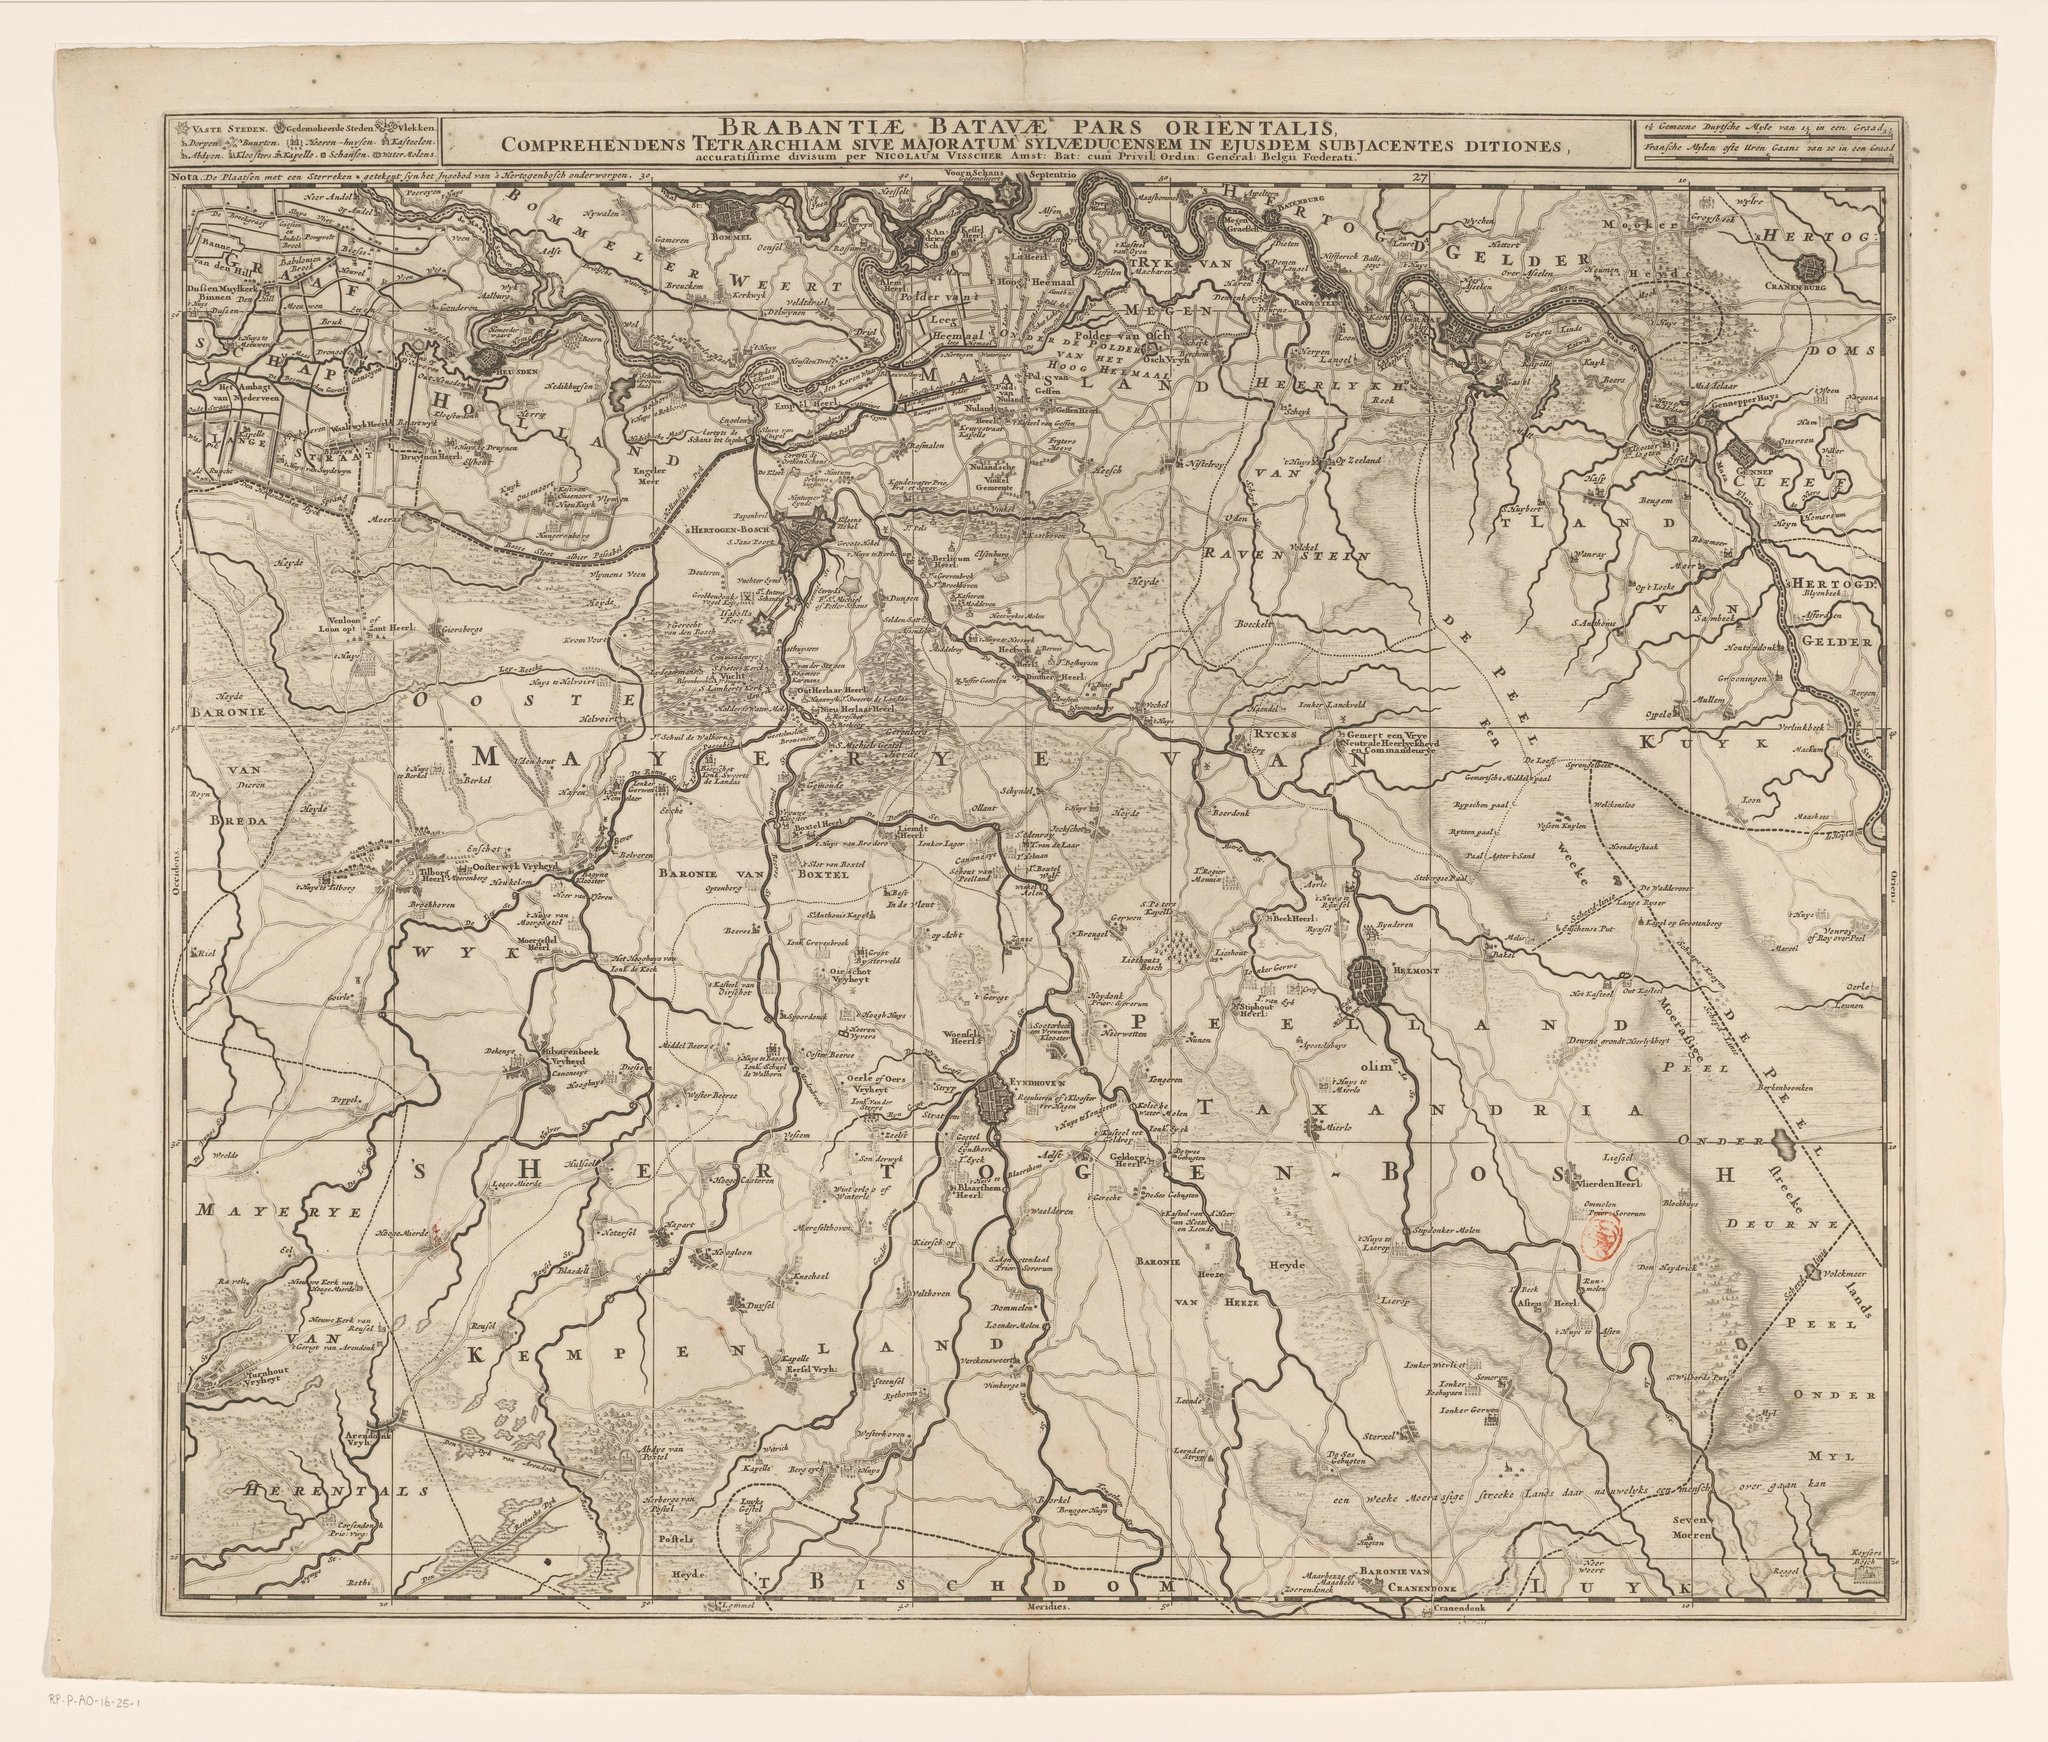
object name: map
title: Brabantiae Batavae pars orientalis comprehendens tetrarchiam sive majoratum Sylvaeducensem in ejusdem subjacentes ditiones (...)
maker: Anonymous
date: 1677-1720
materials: paper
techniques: engraving, etching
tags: maps of separate countries or regions, brabant, den bosch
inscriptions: collector's mark: Lugt 195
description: Kaart van het oostelijk deel van Brabant. Titel en privilege in een strook boven de kaart. Legenda linksboven. Schaalstokken rechtsboven: 1 1/2 Gemeene Duytsche Myle van 15 in een Graad / Fransche Mylen ofte Uren Gaens van 20 in een graad. De kaart is voorzien van een coördinaten-net en een gradenverdeling langs de randen.